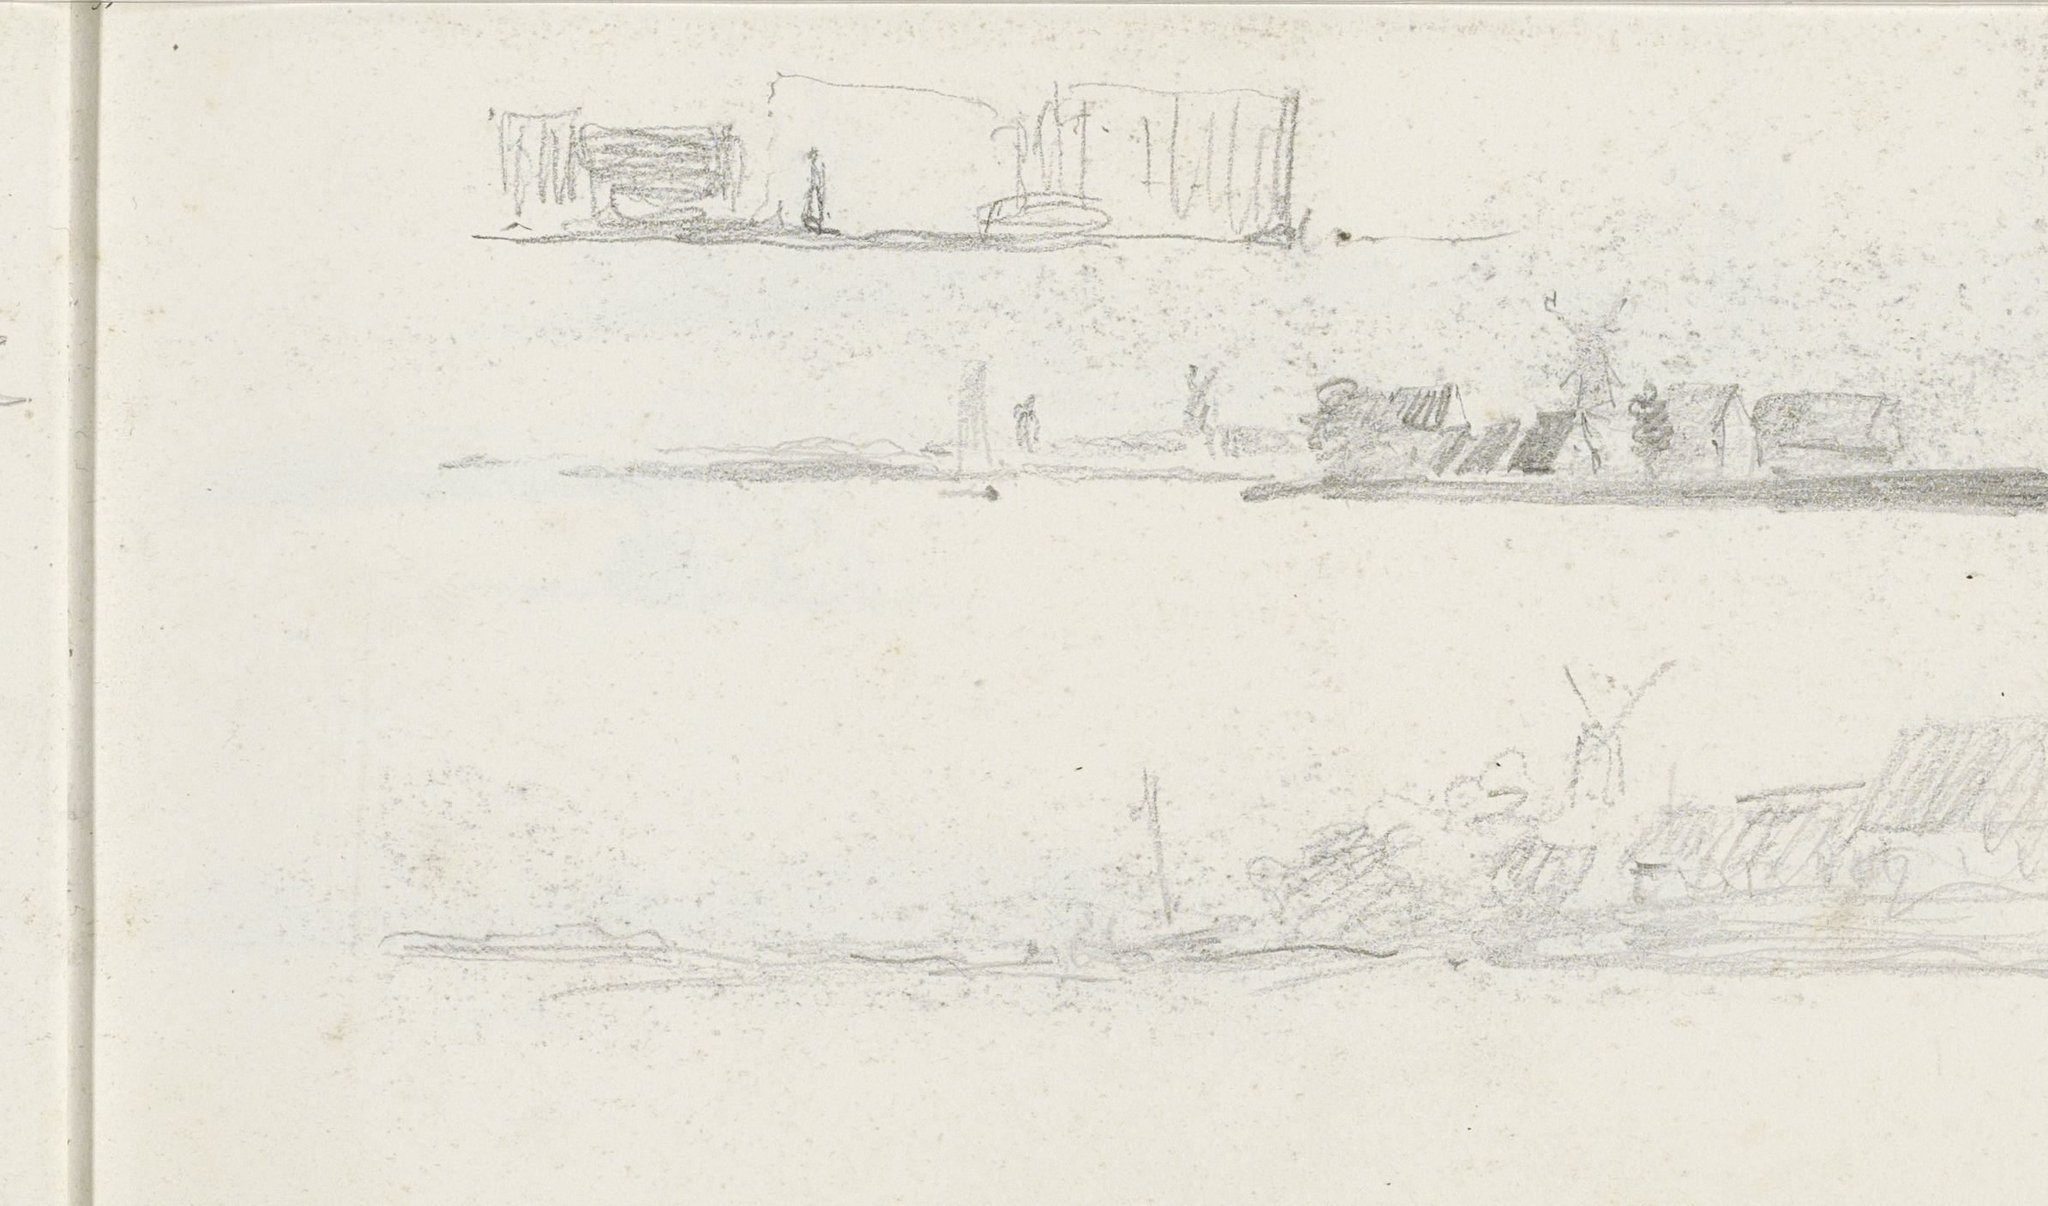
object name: sketchbook leaf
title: Riviergezichten met huizen en molens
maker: petrus johannes schotel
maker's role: draughtsman, painter, print maker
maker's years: 1808-1865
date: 1841-1865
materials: paper, pencil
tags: river, windmill in landscape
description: Pagina 51 uit een schetsboek met 80 pagina's.